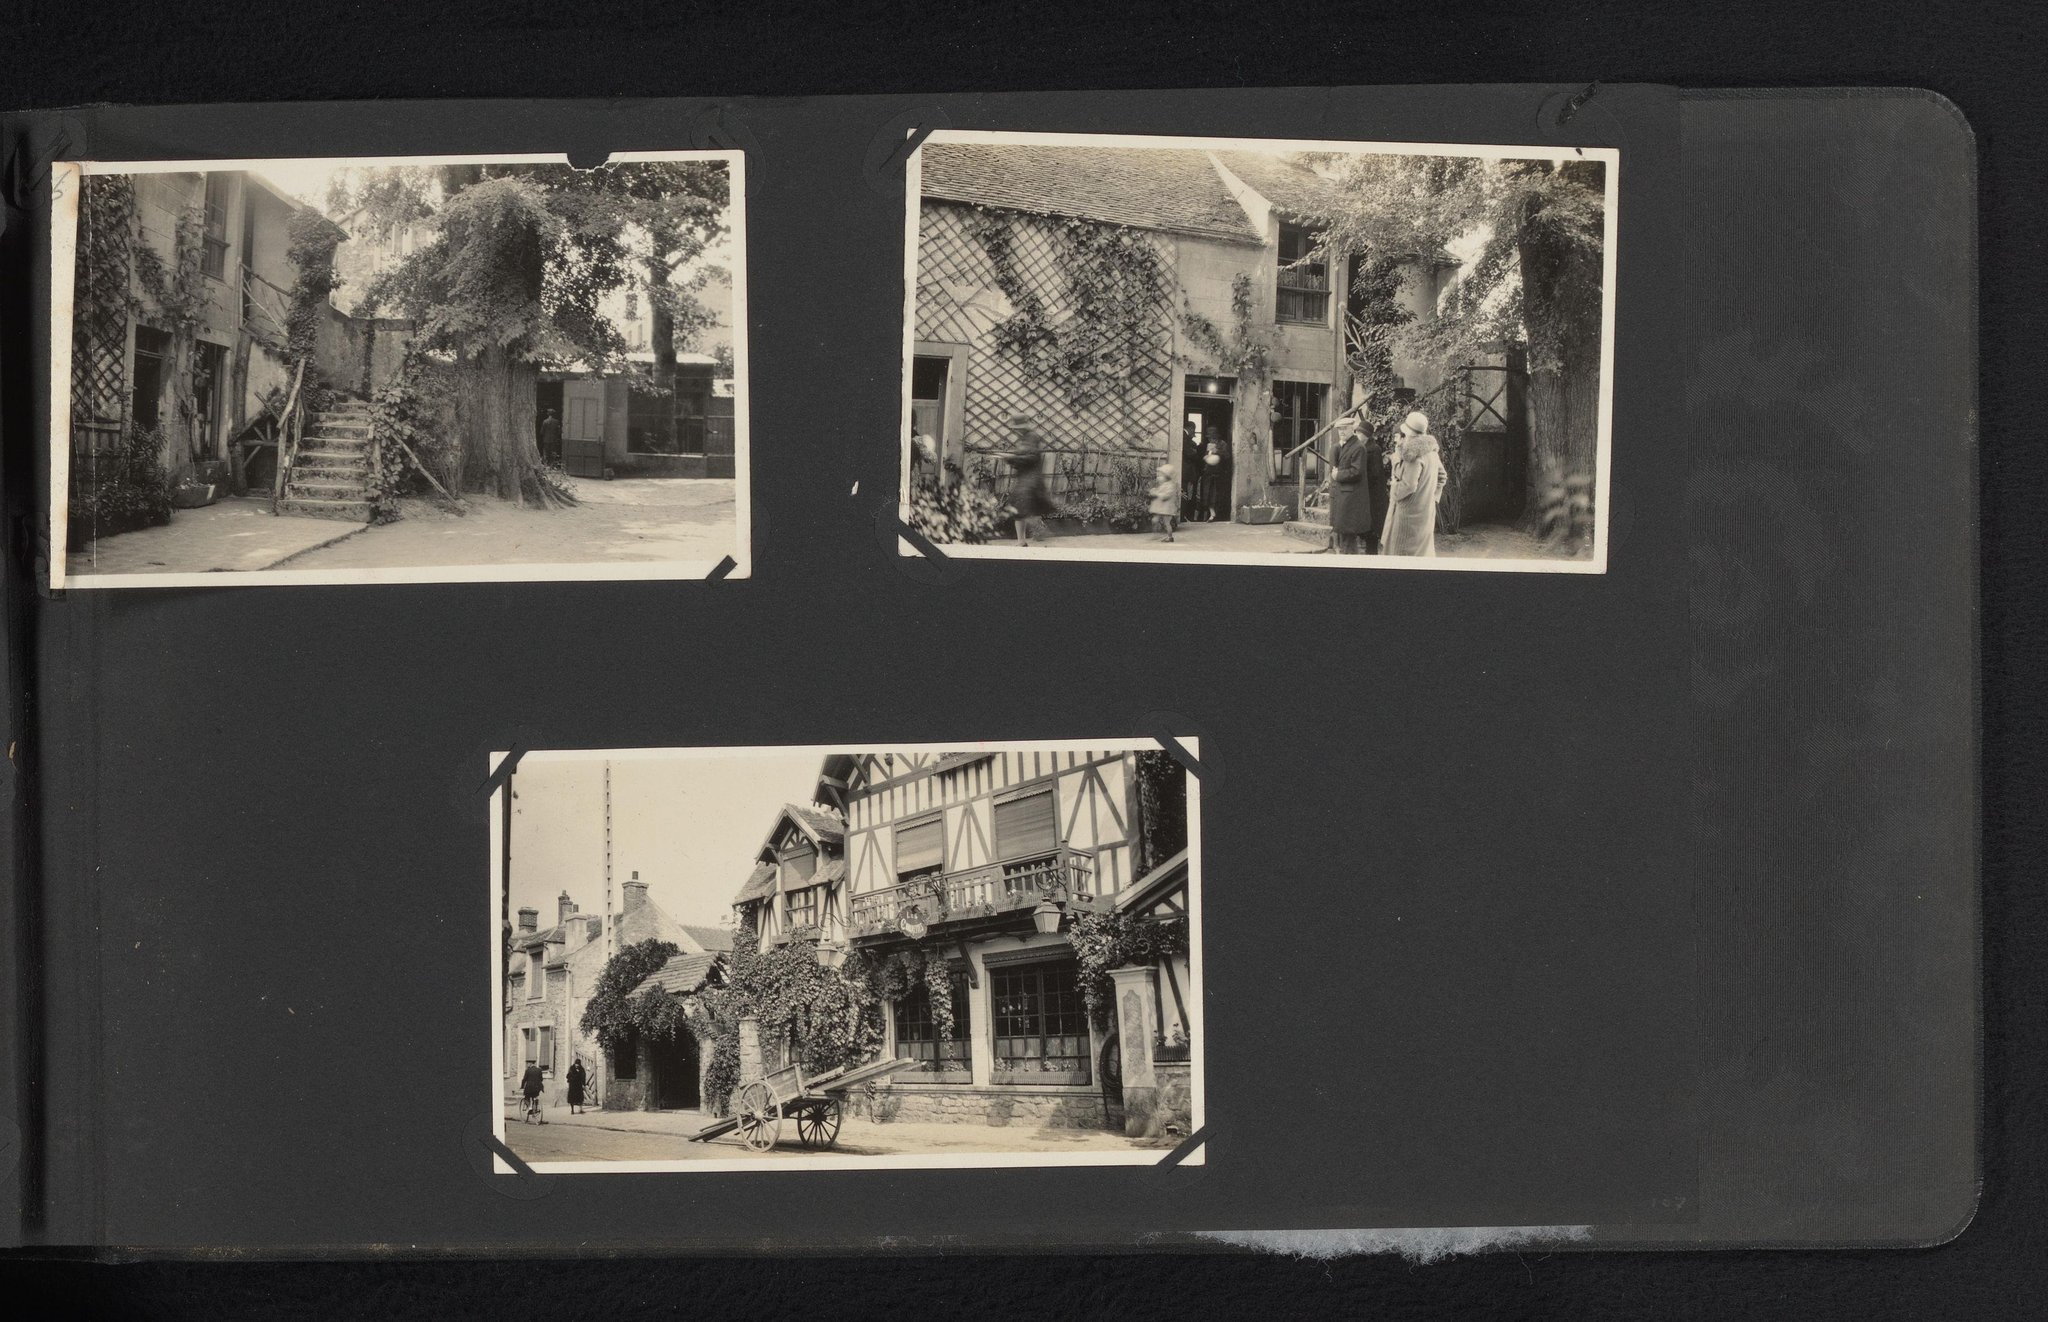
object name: album leaf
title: Drie foto's van het atelier en huis van Jean-François Millet te Barbizon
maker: hendrik herman van den berg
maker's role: amateurfotograaf, jurist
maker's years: 1875-1944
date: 1908-1929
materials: paper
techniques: gelatin silver print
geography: barbizon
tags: cottage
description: Deze foto's maken deel uit van een album.